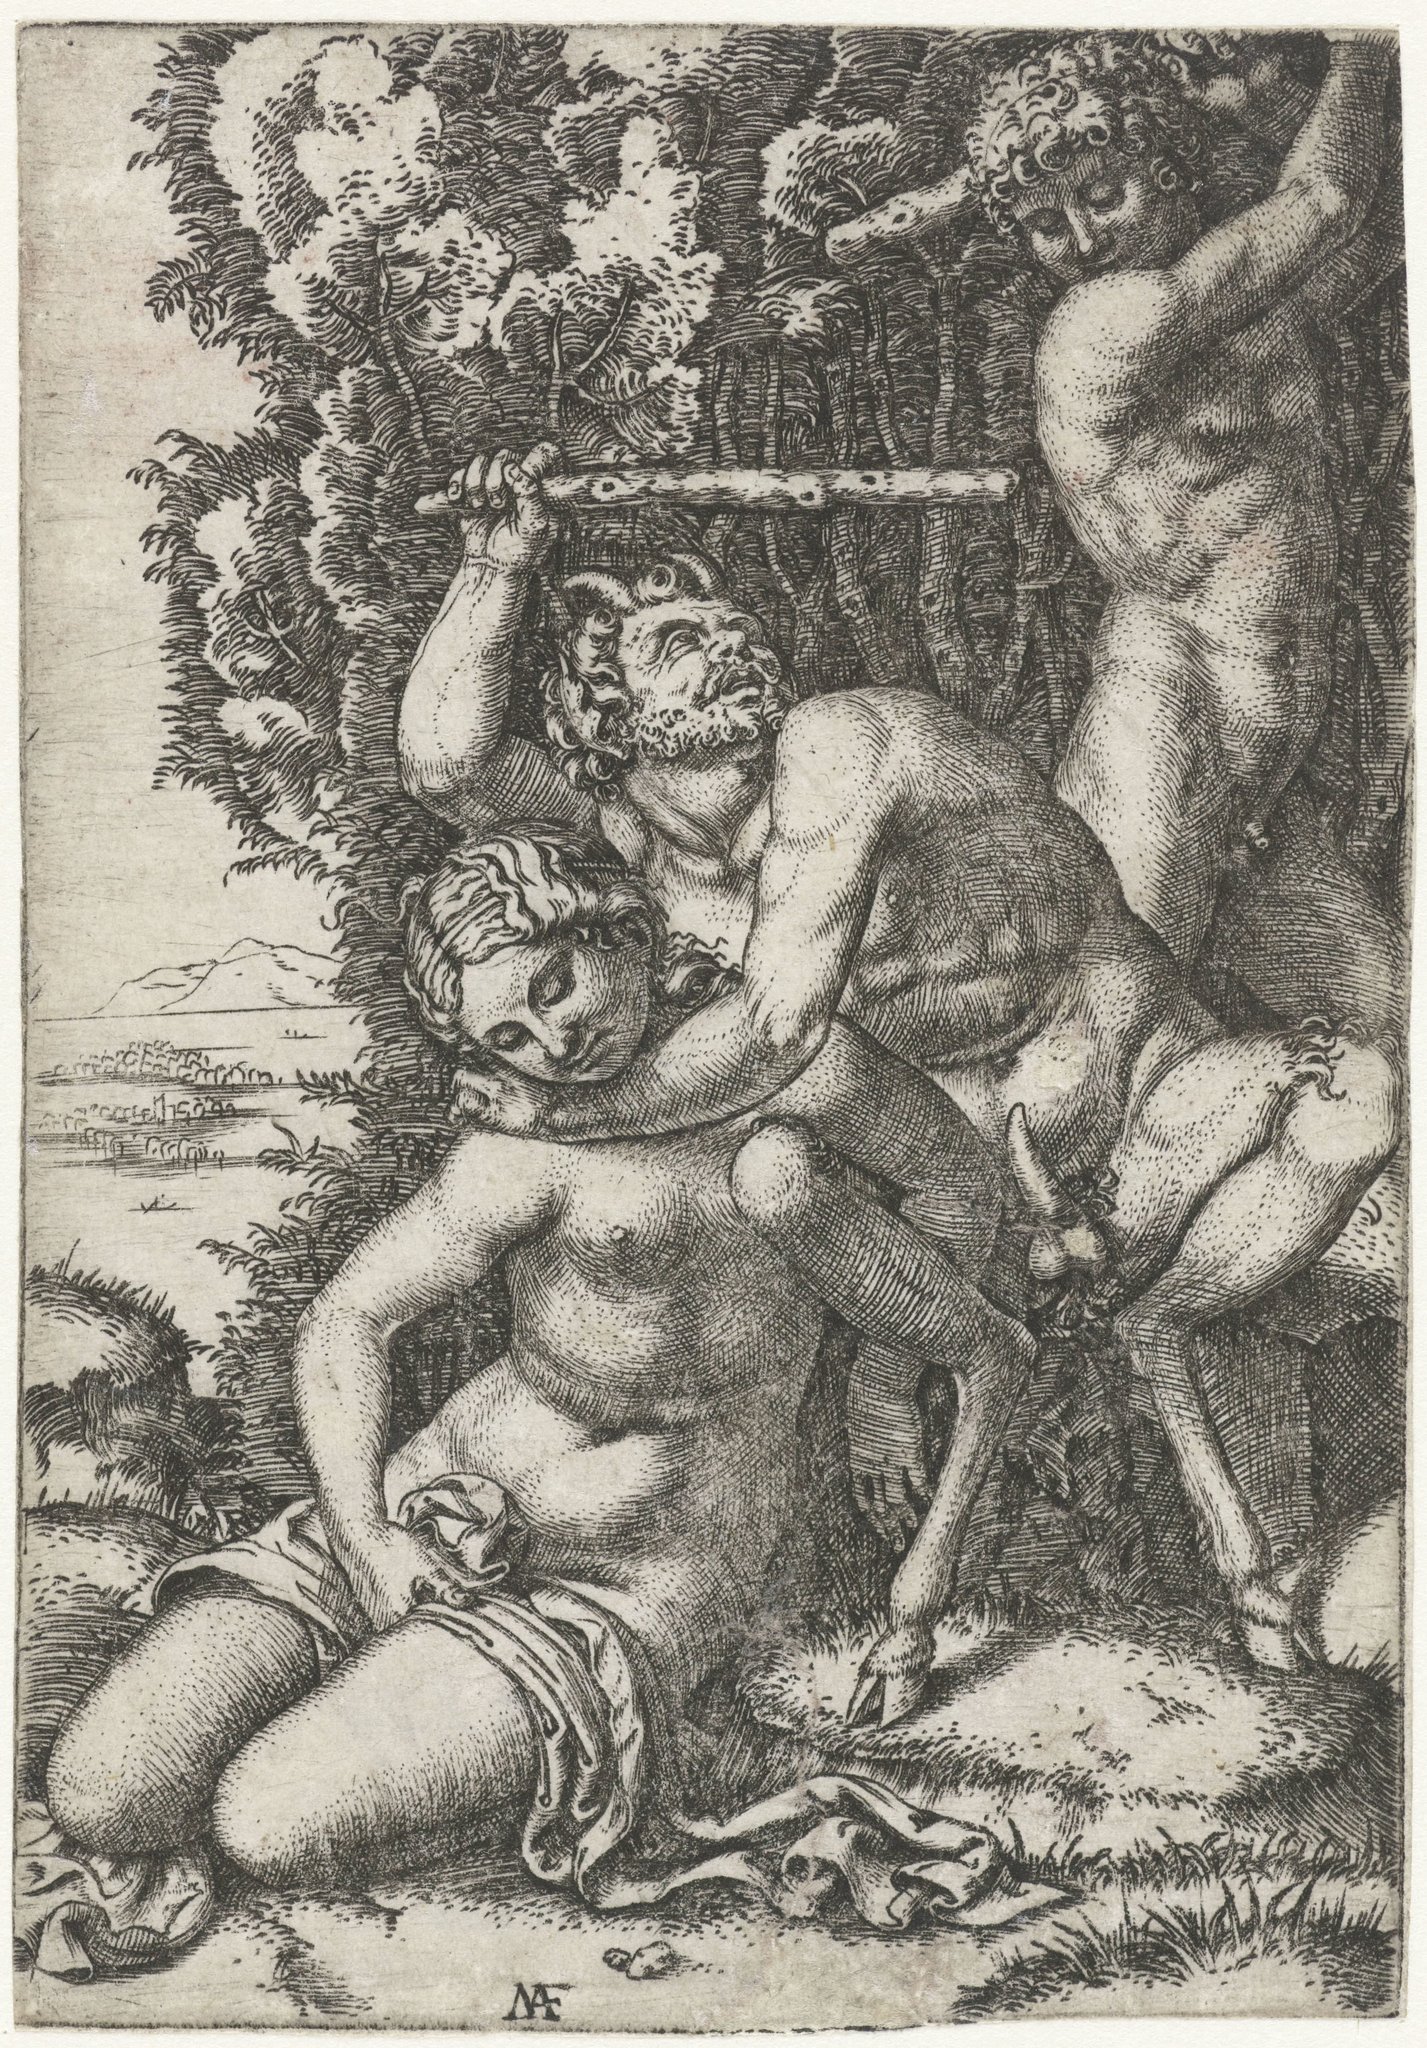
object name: print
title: Satyr en jongeman vechtend om nimf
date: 1511-1525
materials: paper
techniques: engraving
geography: italy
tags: satyr(s) pursuing nymph(s)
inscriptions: collector's mark: Lugt 240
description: Prent naar ontwerp of gravure van Francesco Francia.